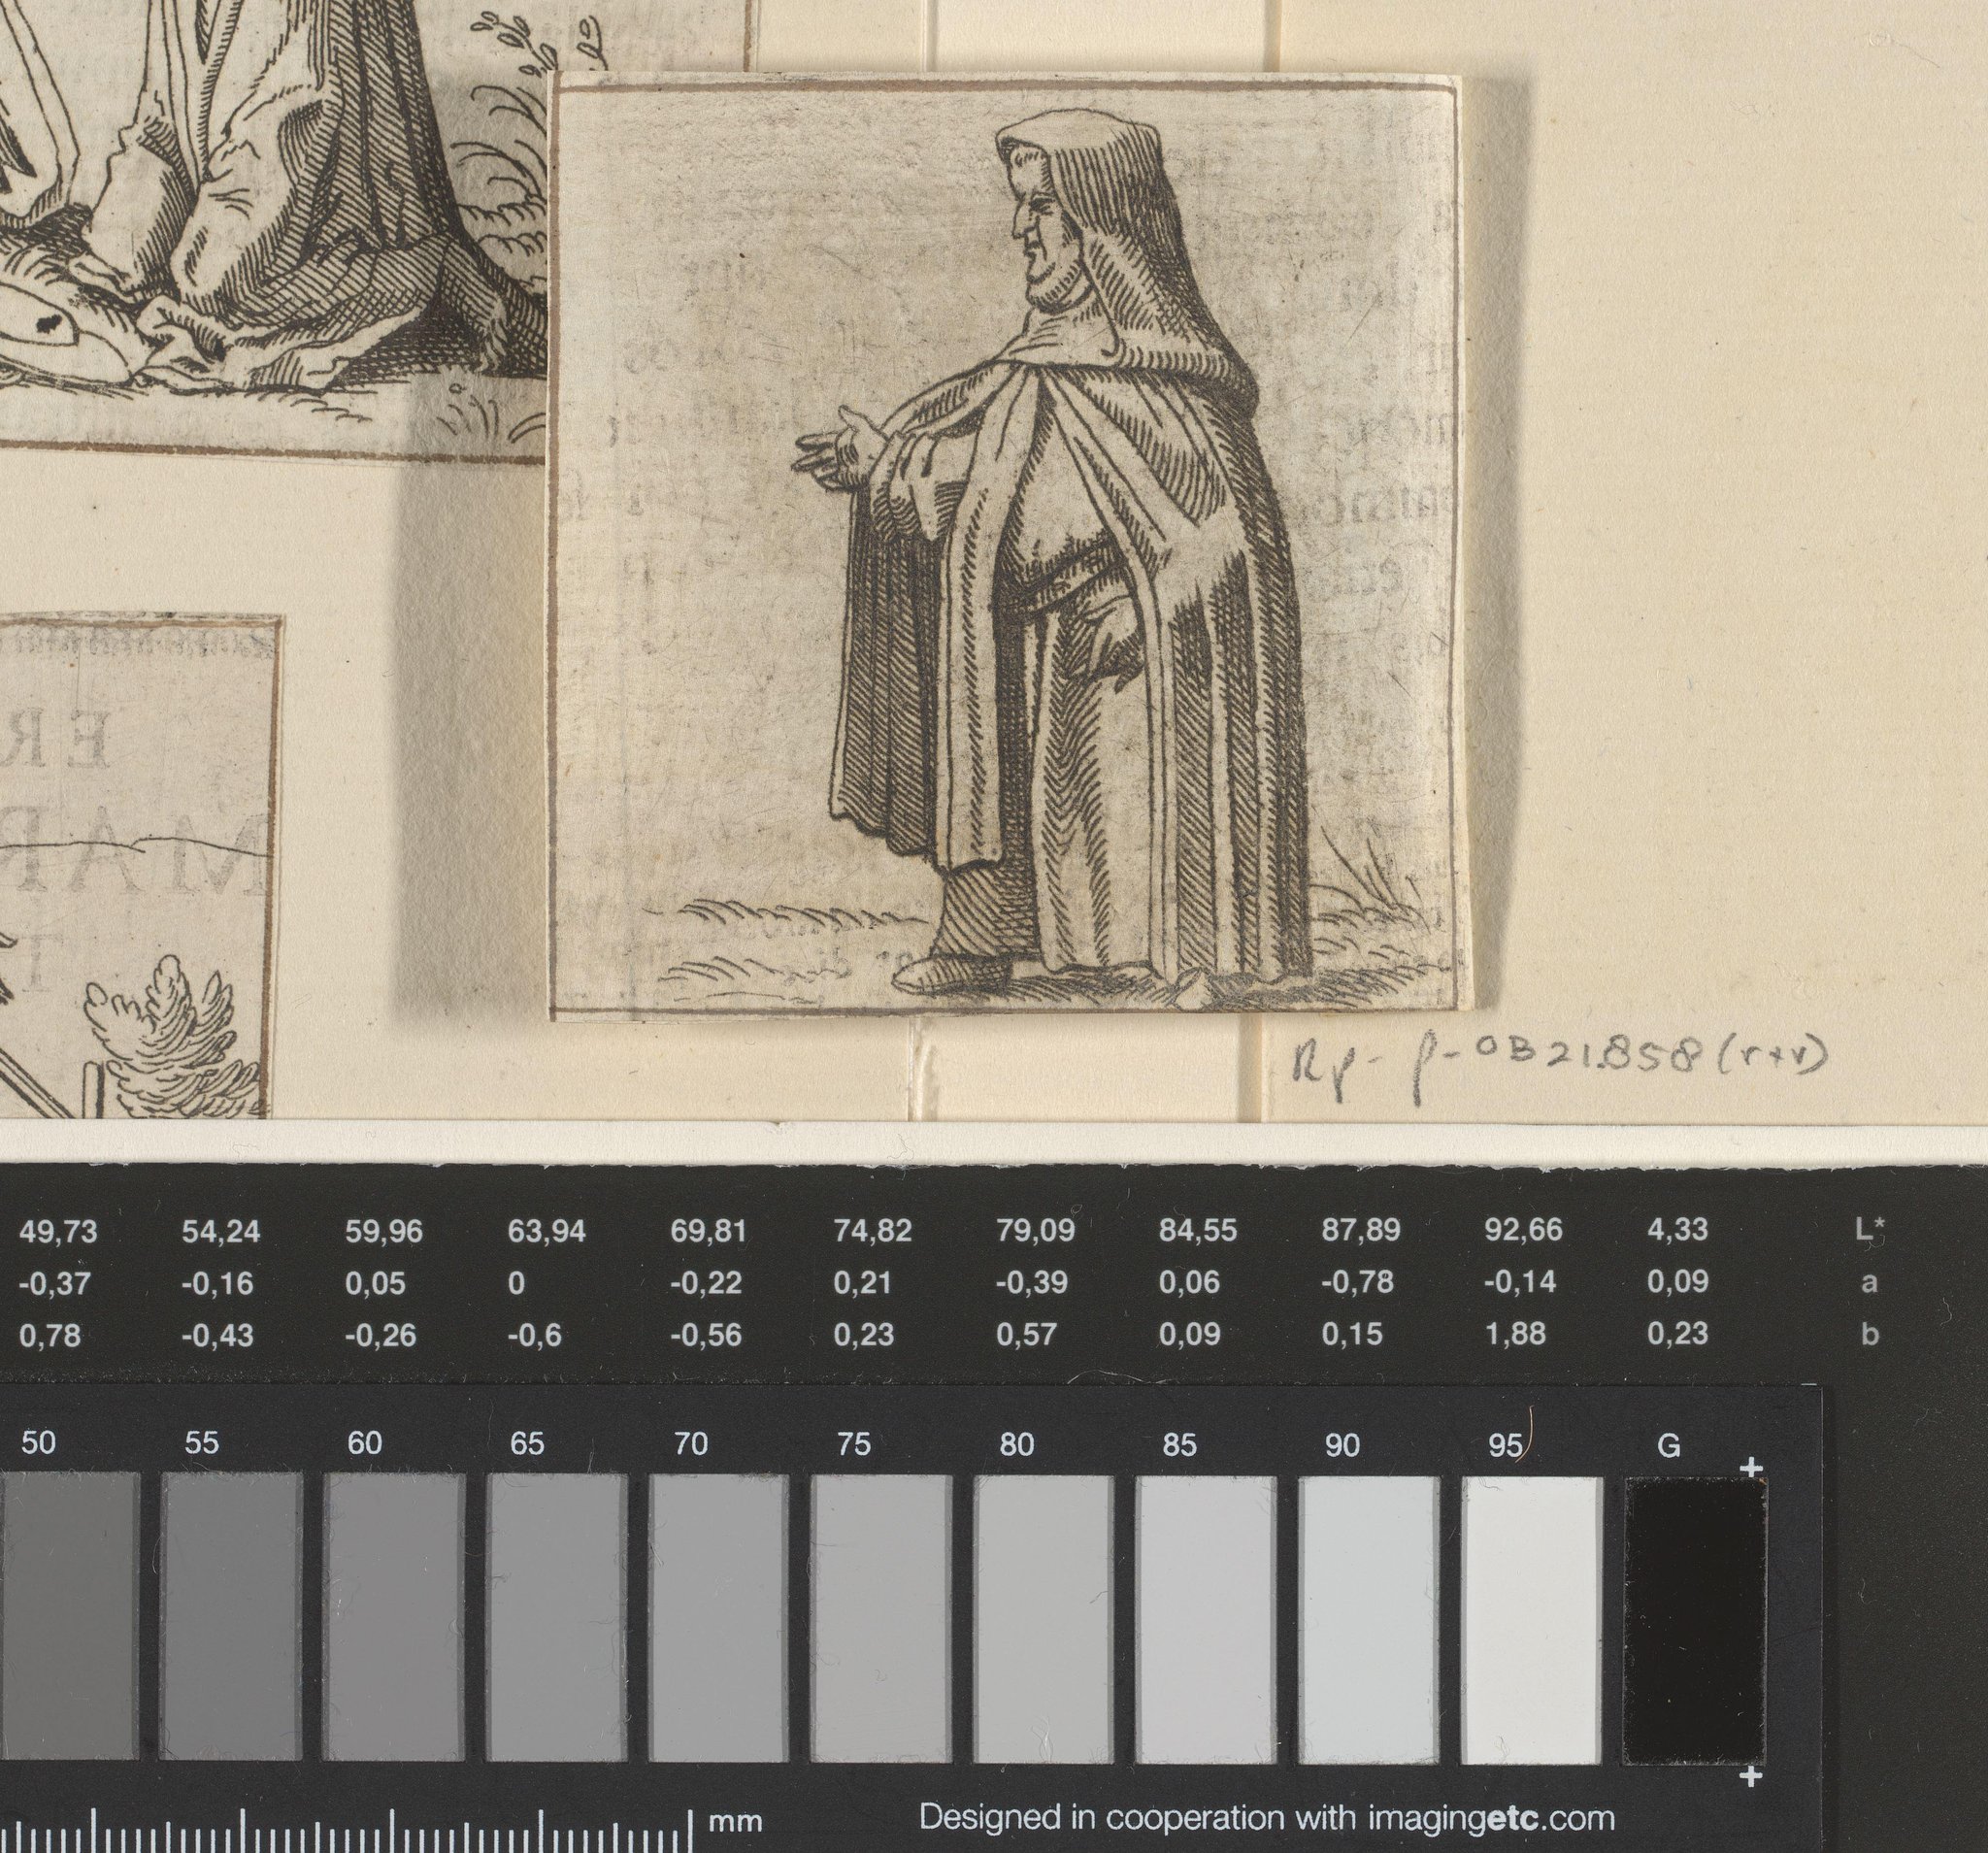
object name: print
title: Illustraties uit de Lof der Zotheid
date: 1516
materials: paper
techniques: etching, letterpress printing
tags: rotterdam, desiderius erasmus, fat (human type), monk(s), friar(s), folly, foolishness; 'pazzia', 'sciocchezza', 'stoltitia' (ripa)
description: Prent afkomstig uit: Erasmus, Desiderius. Morias enkomion (...). Bazel: Johann Rudolf Genath, 1676. De prenten hierin zijn naar tekeningen die Hans en Ambrosius Holbein maakten voor de theoloog Oswald Myconius in diens uitgave van de Moriae encomium (Lof der Zotheid) van 1516.